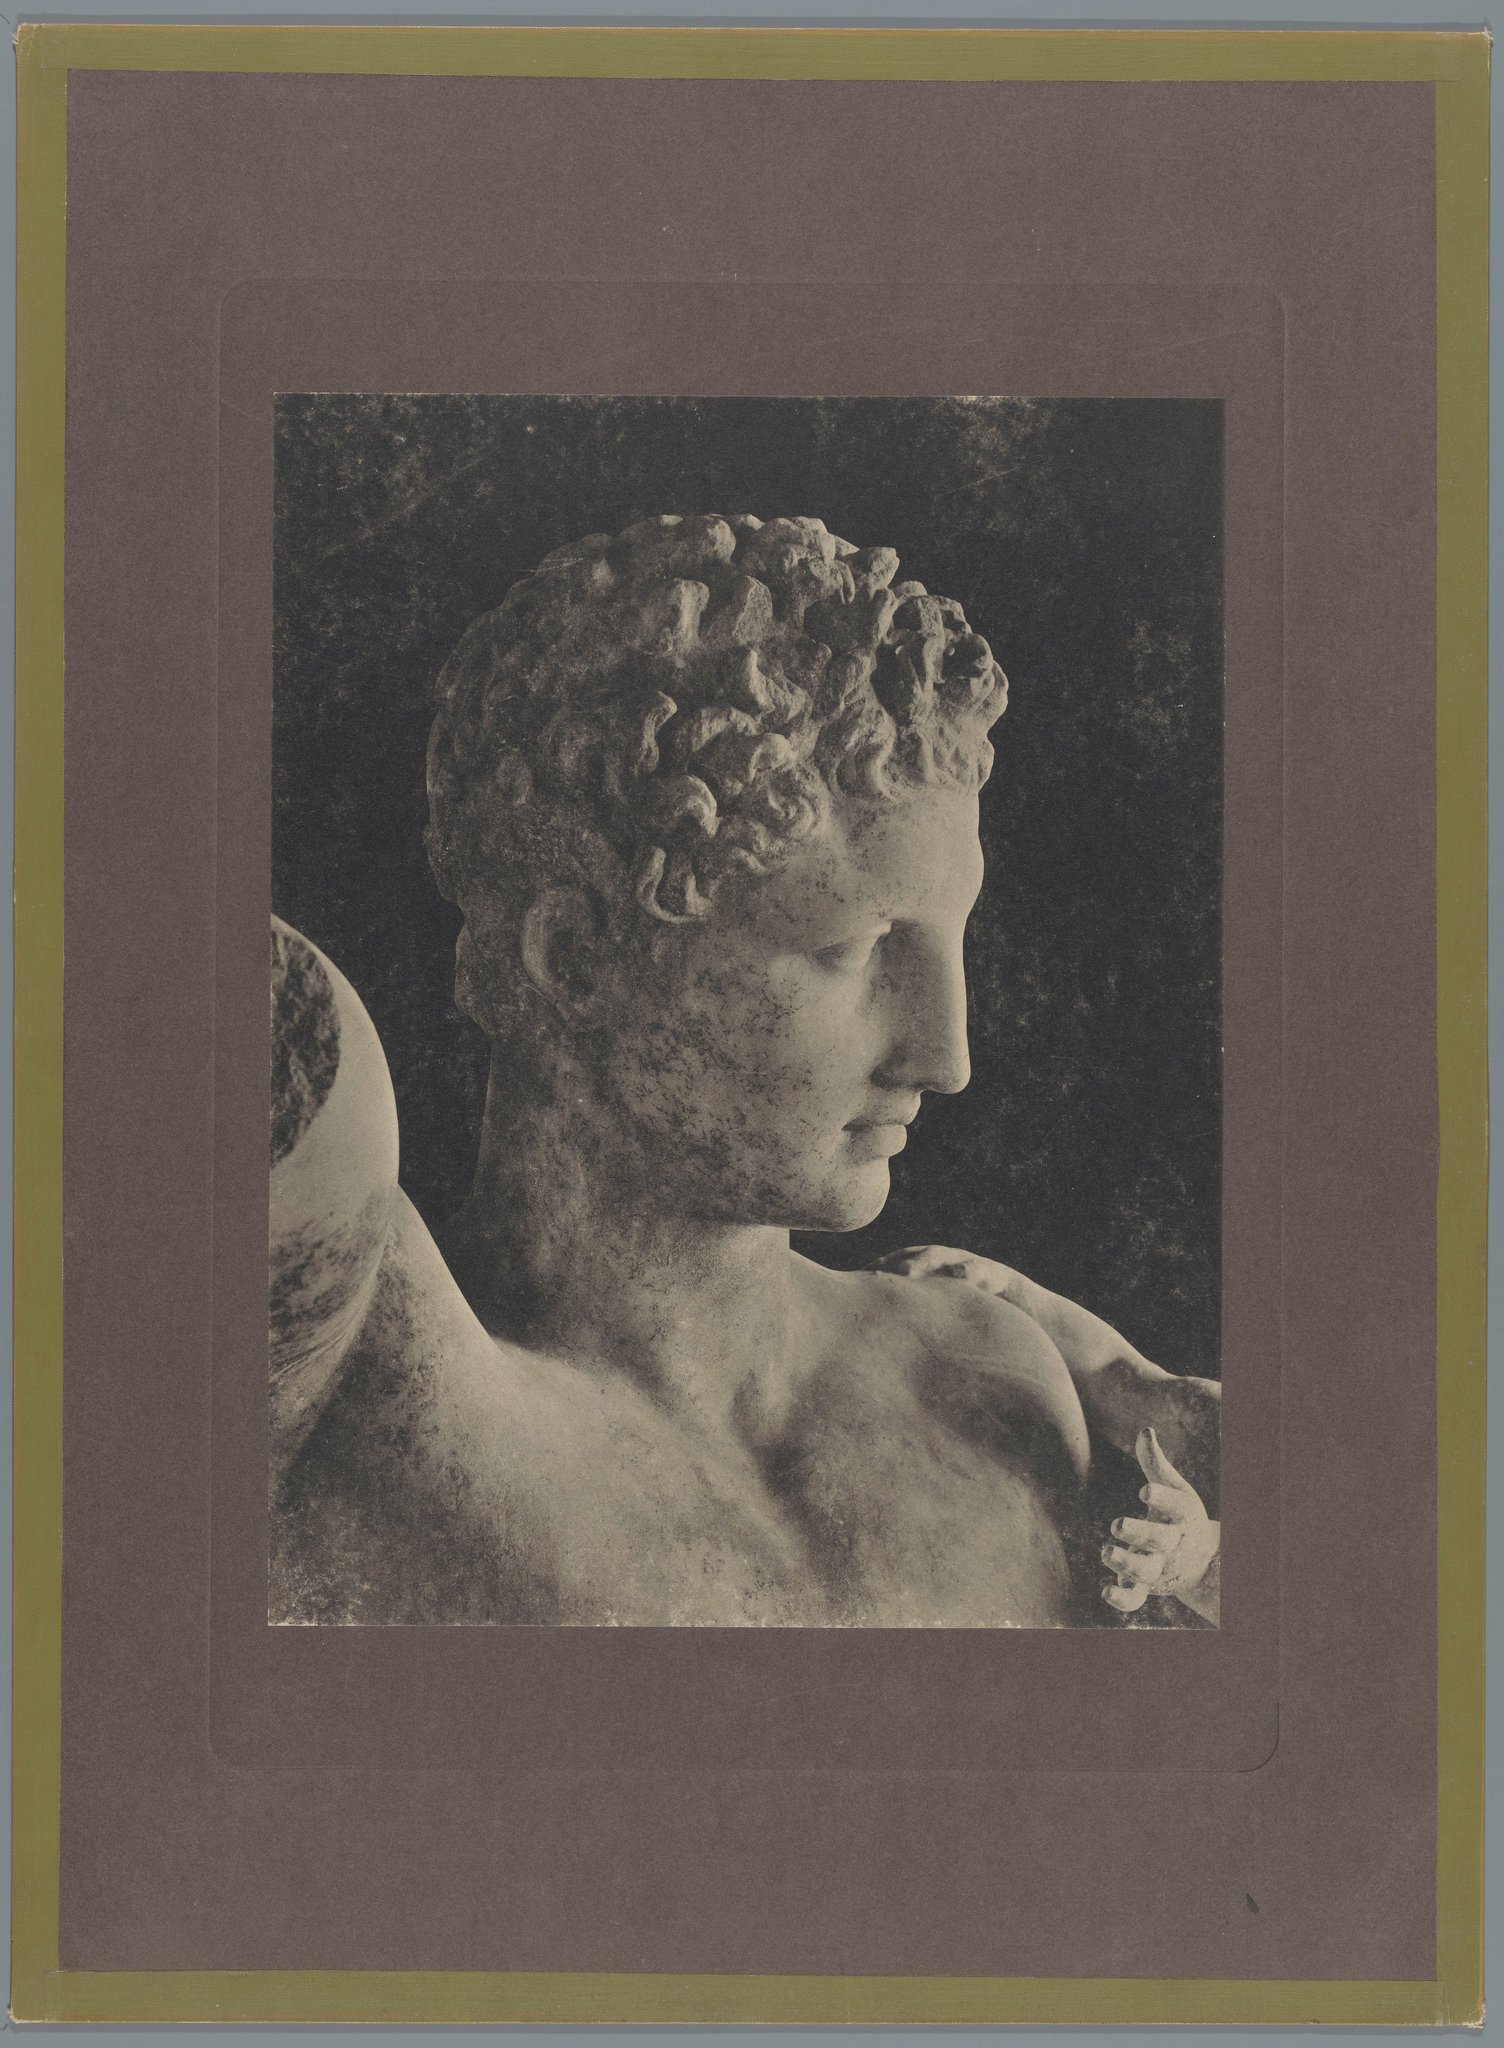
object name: photograph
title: Detail van het hoofd van een sculptuur van Hermes door Praxiteles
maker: Anonymous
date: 1898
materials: cardboard, paper, ink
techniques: photograph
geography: munich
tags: (story of) mercury (hermes), monument, statue, europe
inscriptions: inscription:, number: ‘No. 44.’, collector's mark: Lugt 3937